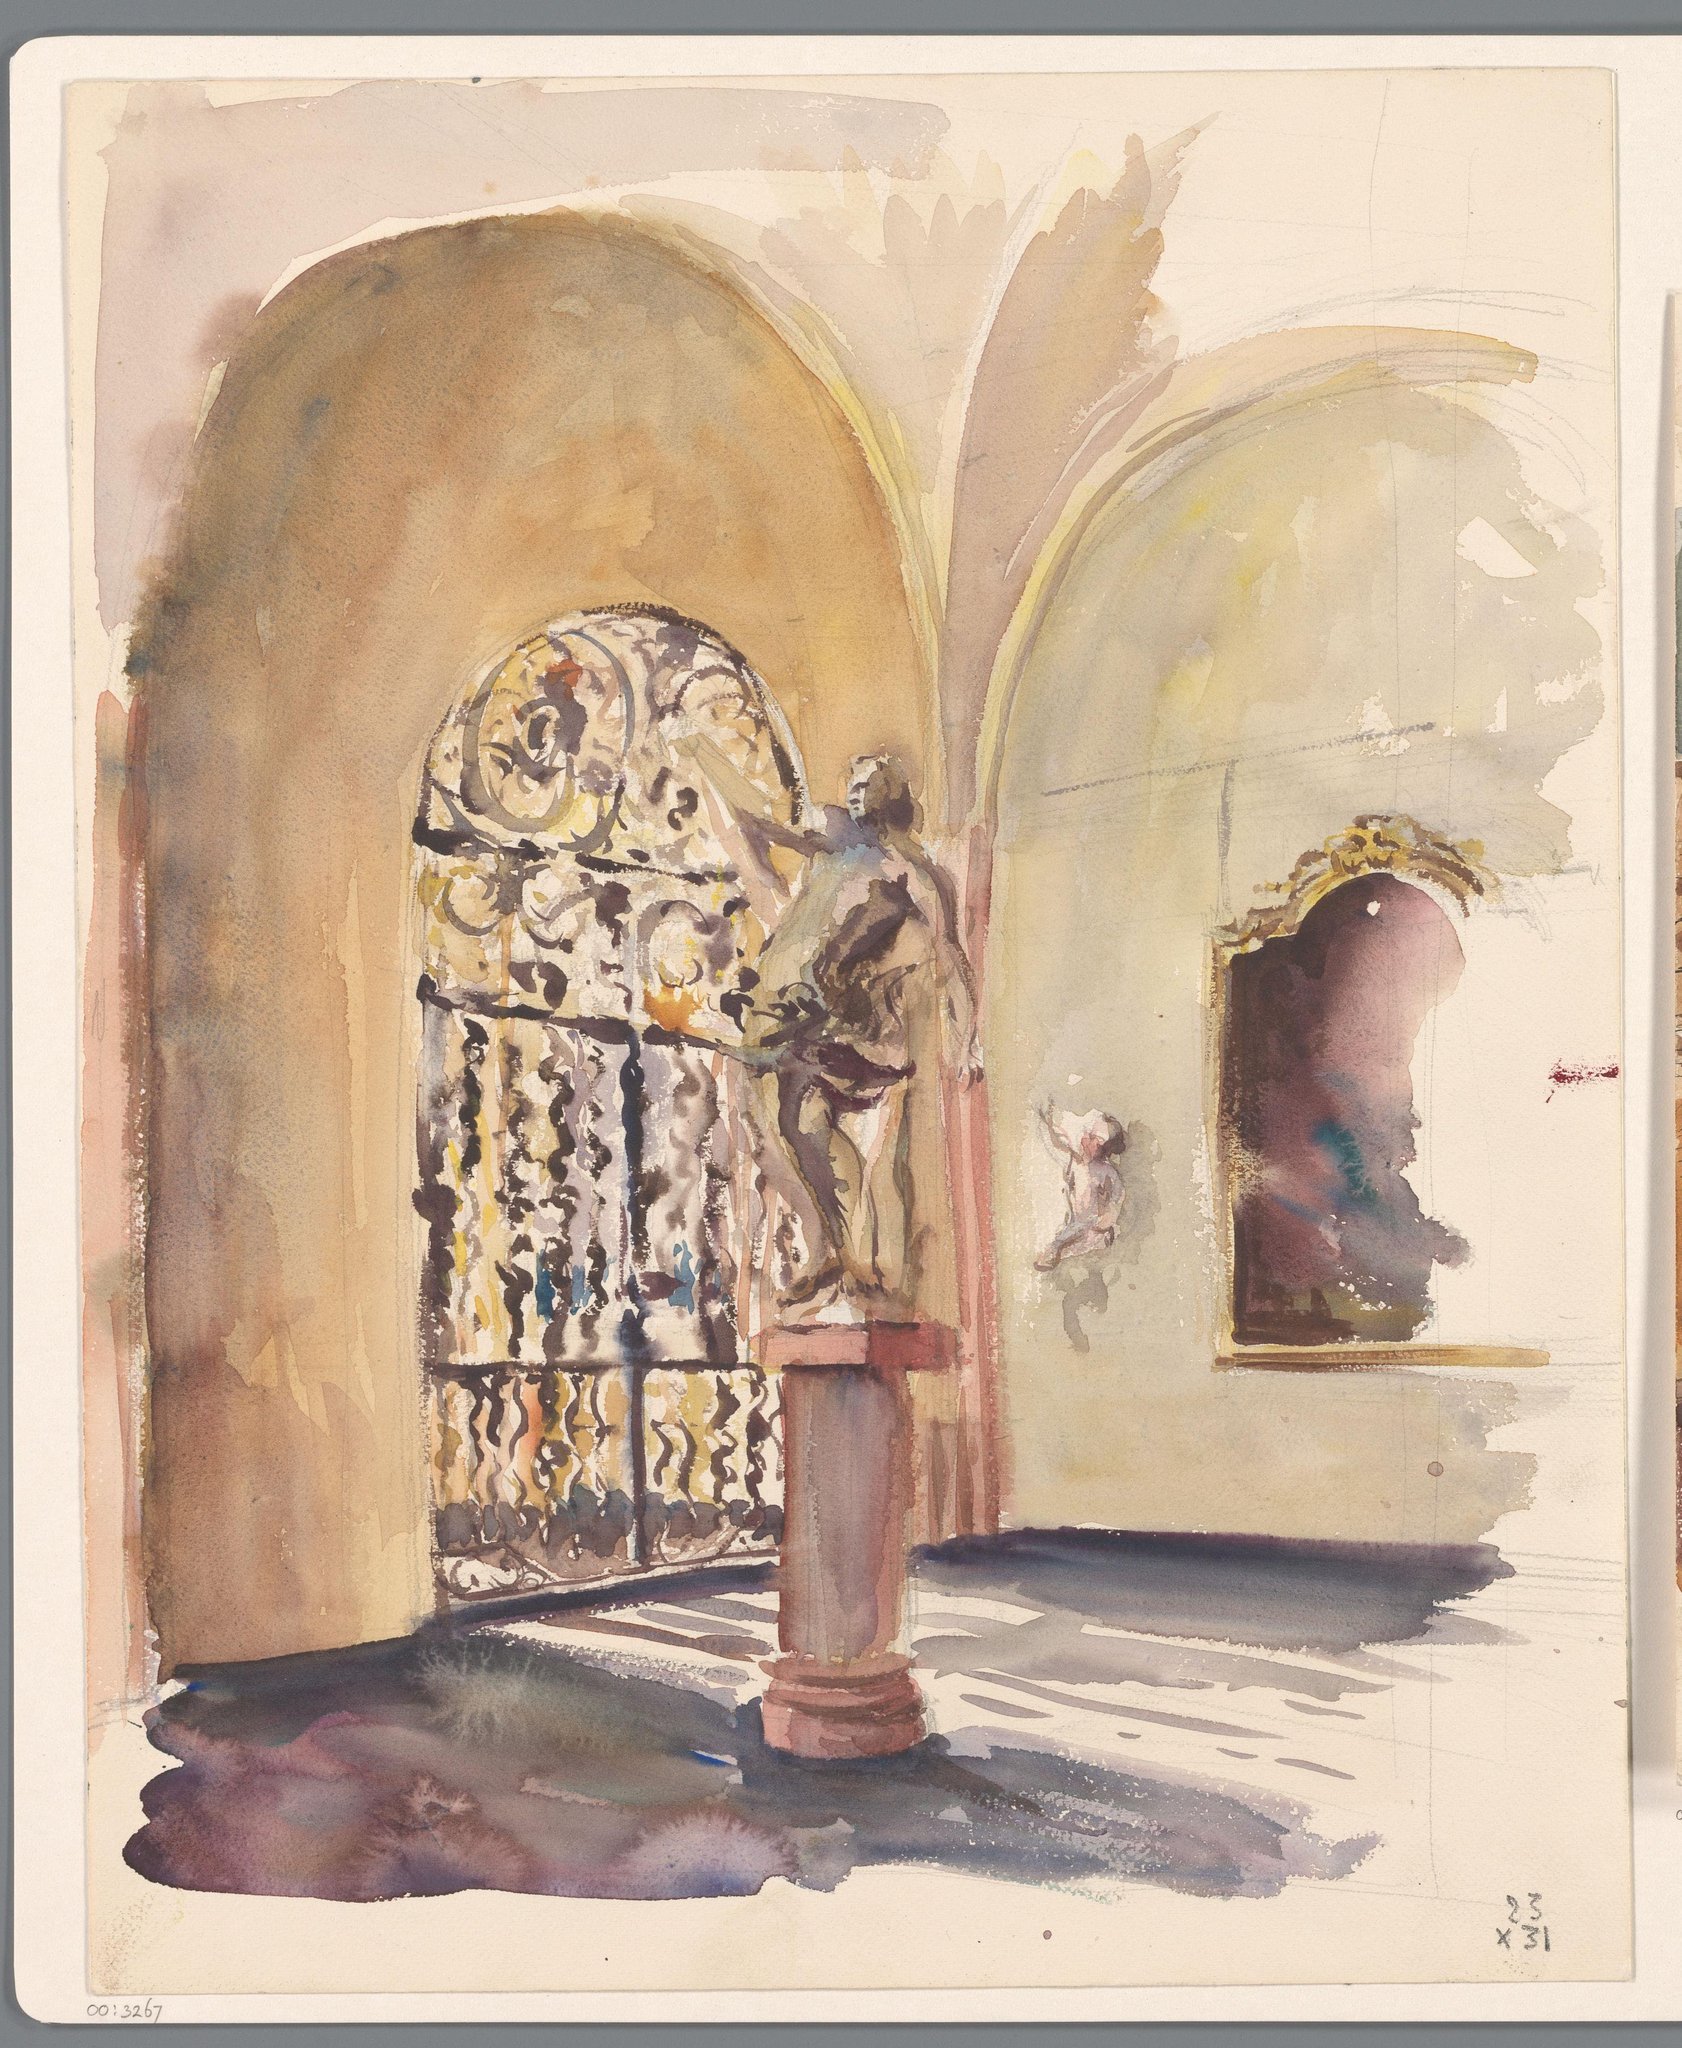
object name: drawing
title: Gezicht in een zaal van het Rijksmuseum: Weense tentoonstelling Pavilloenzaal 1947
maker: van lynden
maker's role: draughtsman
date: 1947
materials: paper, pencil, watercolor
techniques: brush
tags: permanent exhibition, museum